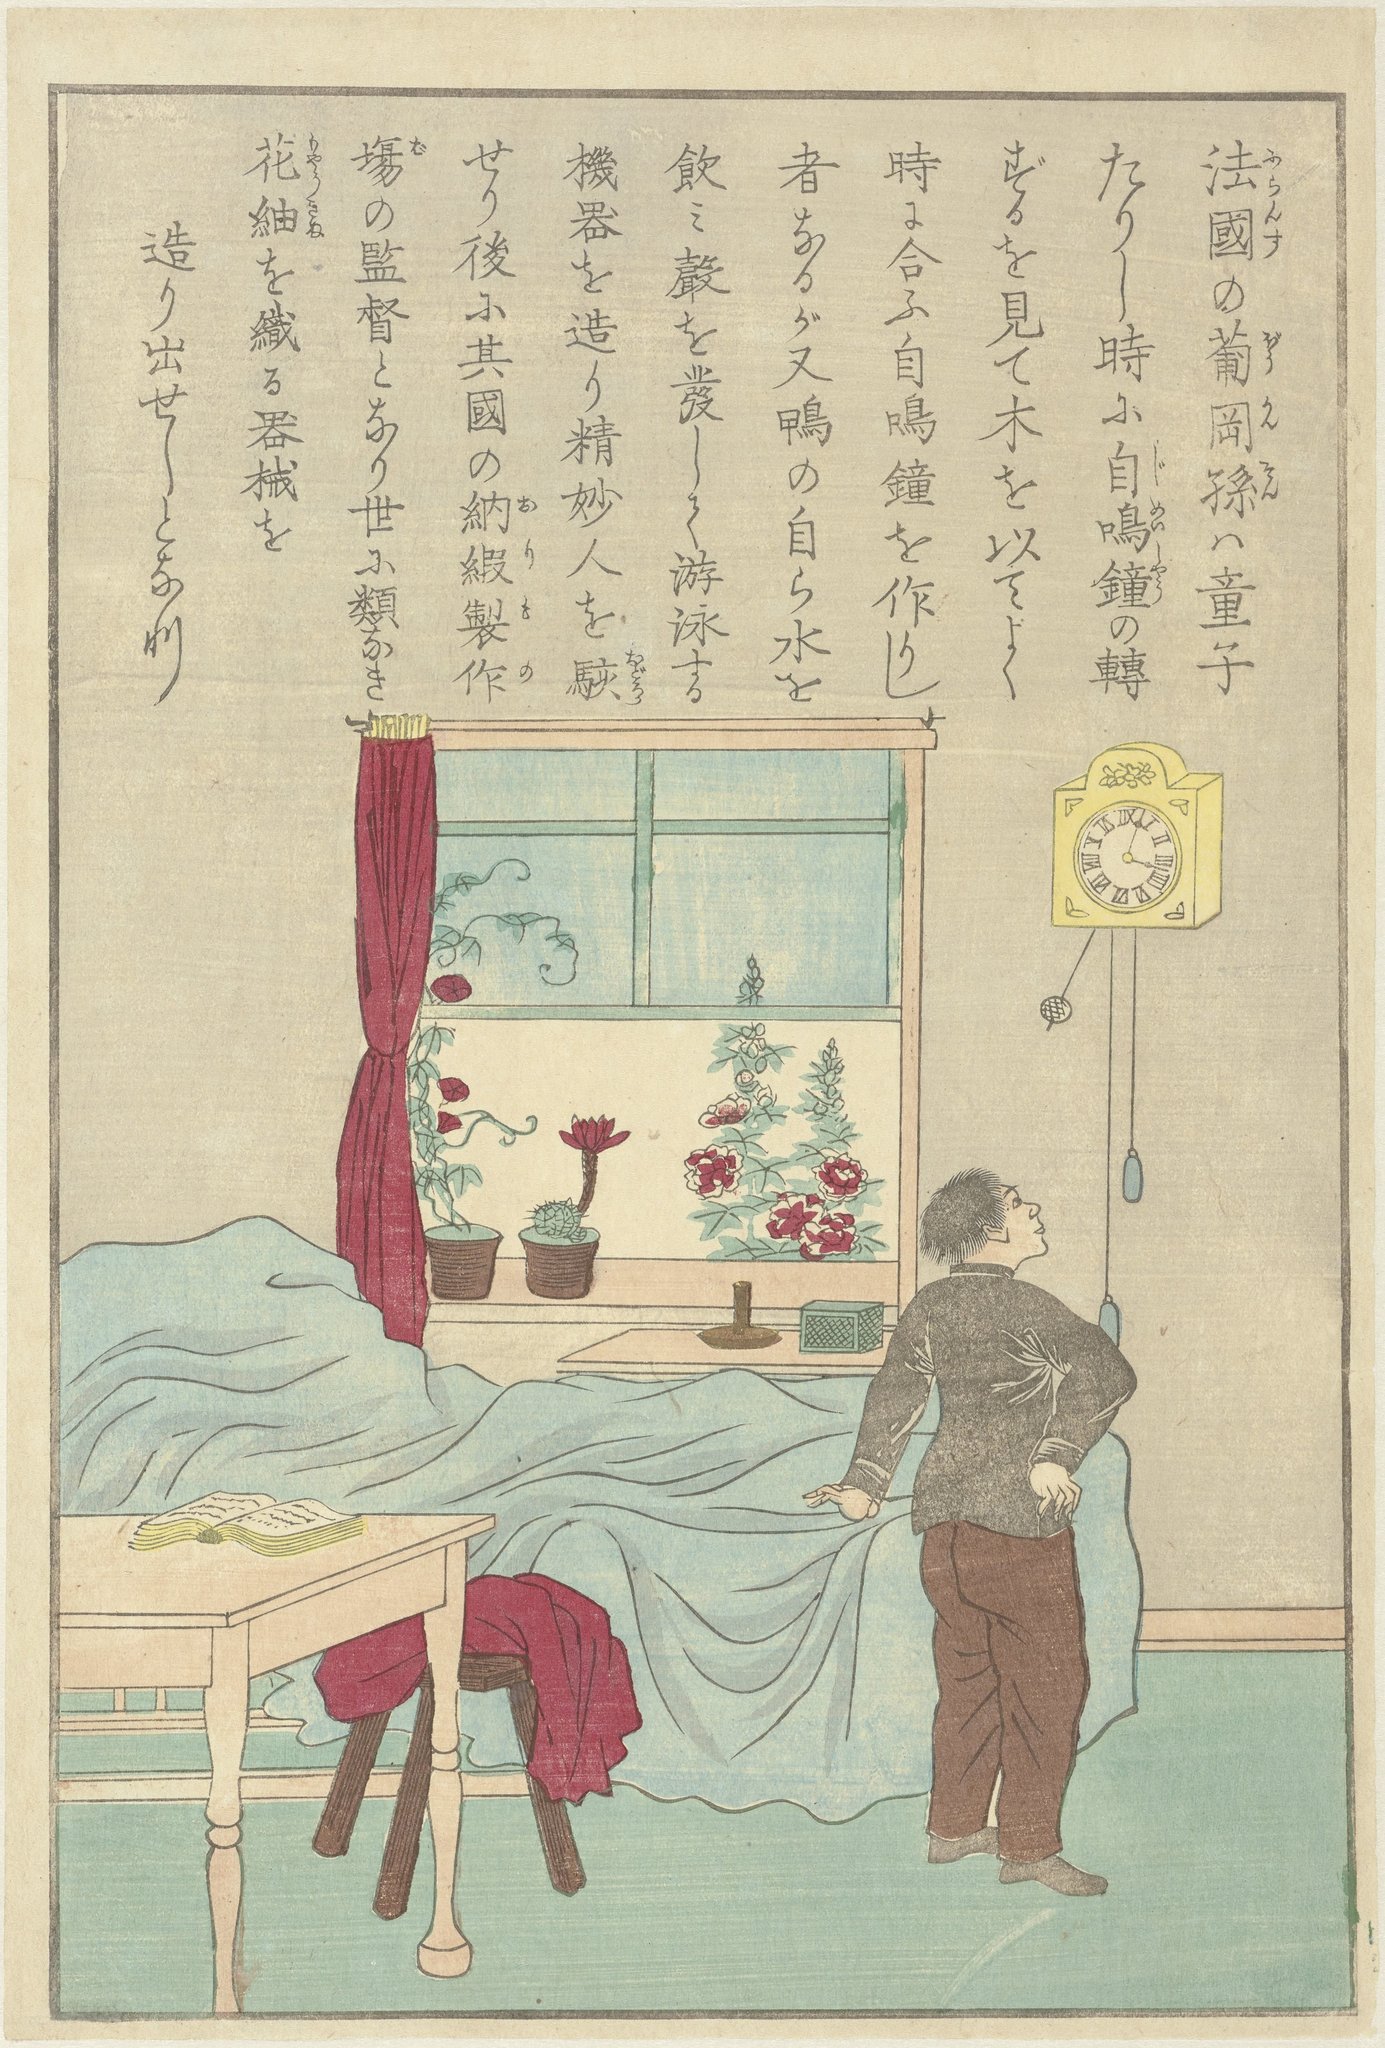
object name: print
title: Man kijkt naar slingerklok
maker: Anonymous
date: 1868-1912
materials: paper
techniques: woodcut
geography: japan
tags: clock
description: Een man staat naast zijn bed en kijkt op naar de slingerklok aan de wand. De Japanse tekst vertelt over de Franse uitvinder van deze klok. (Yokohama-e).